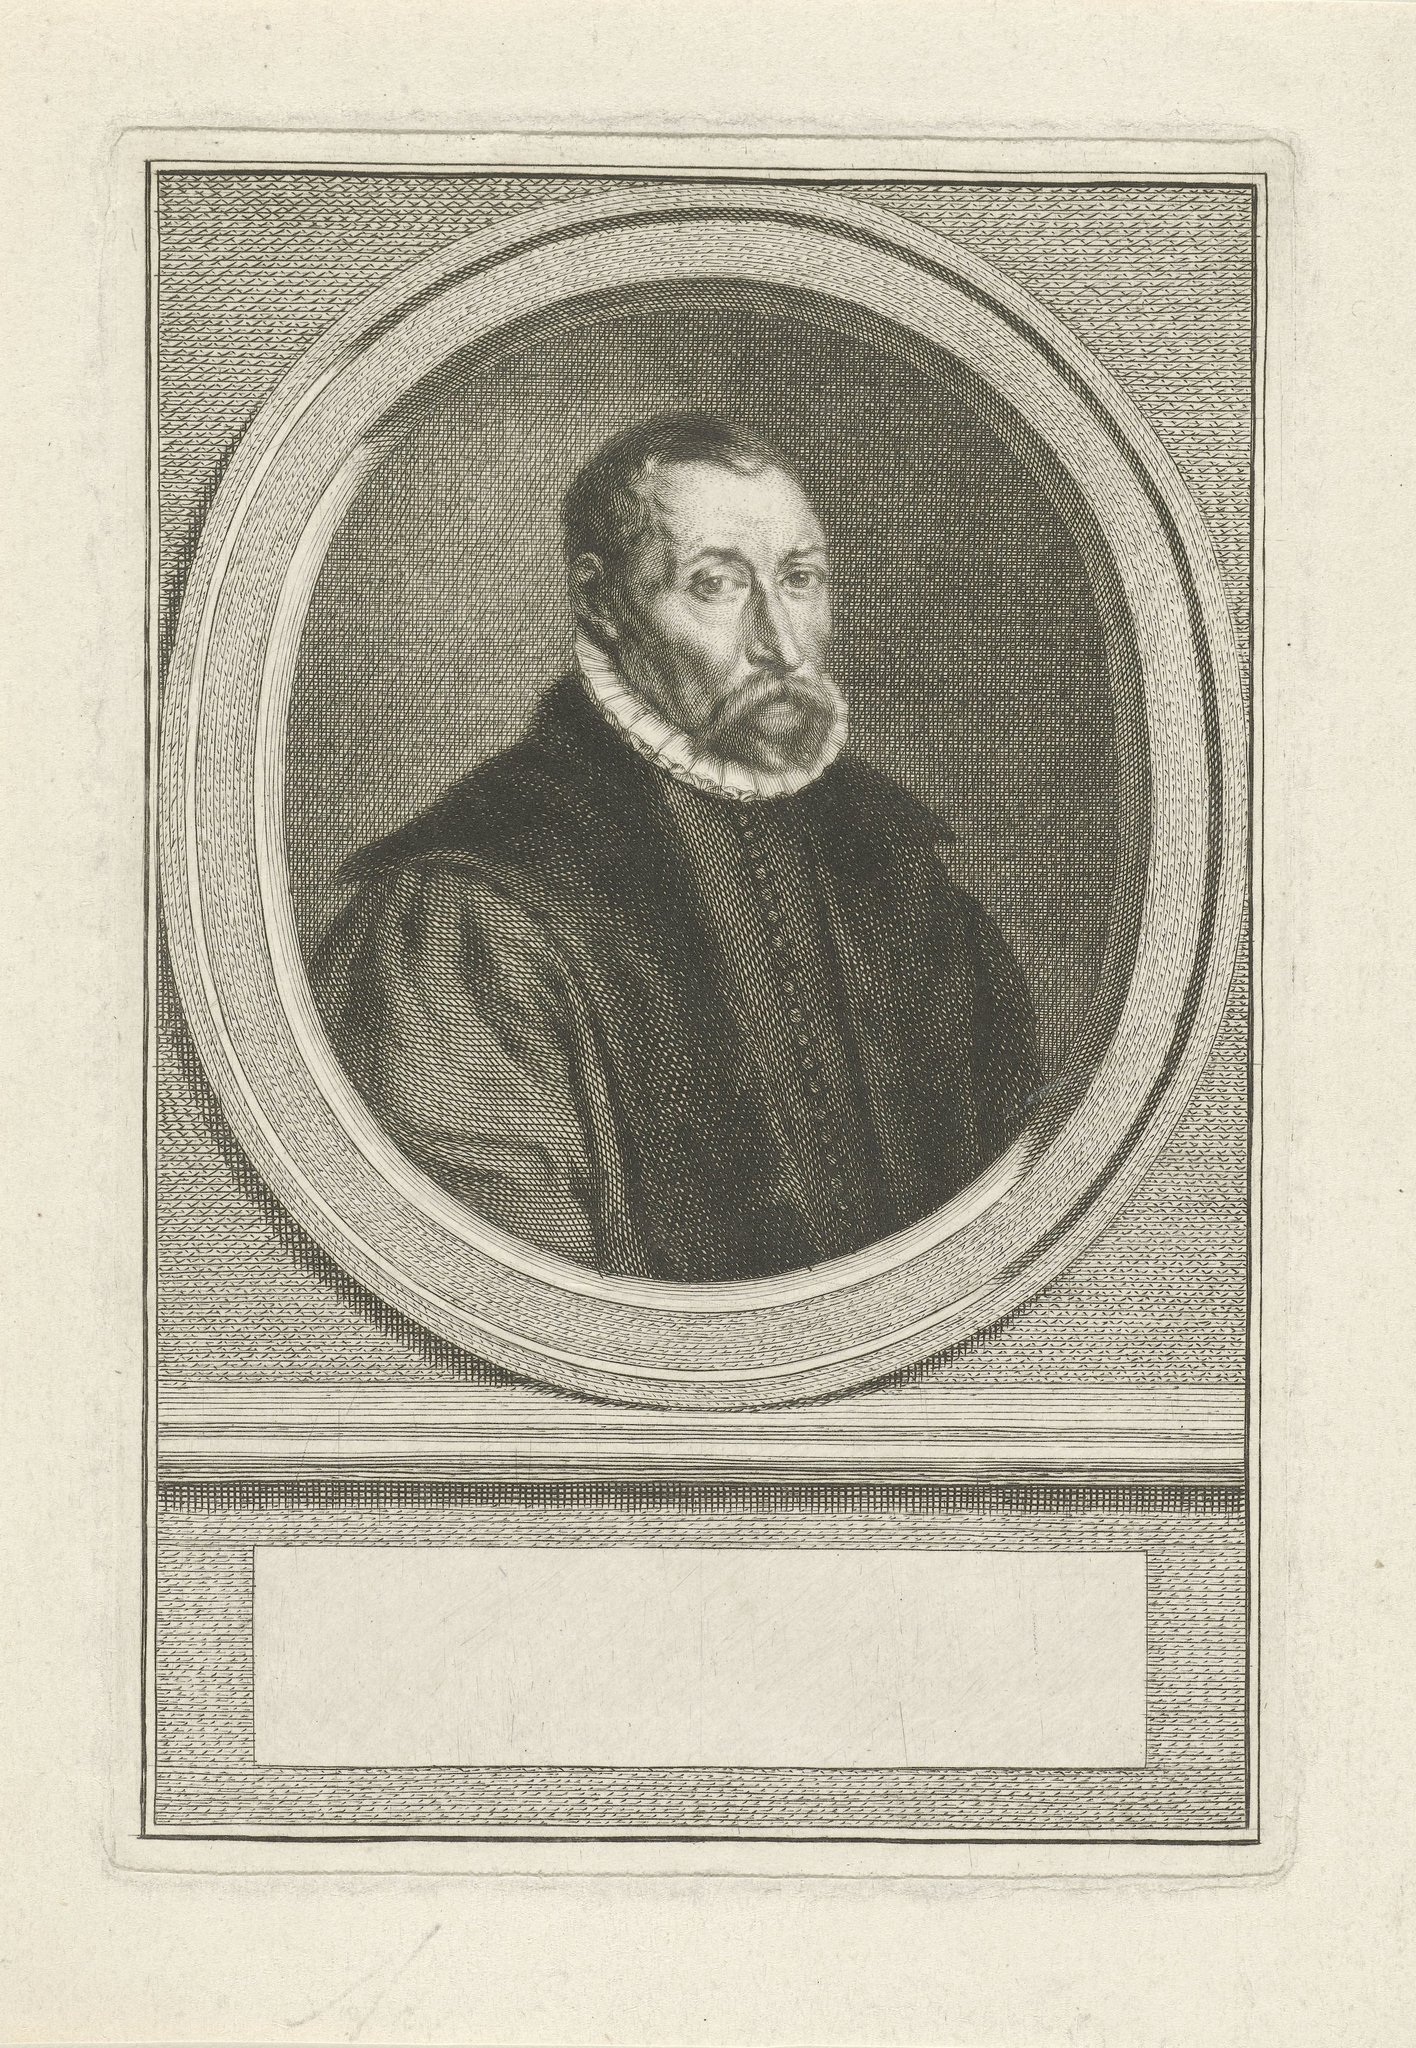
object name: print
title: Portret van Adriaan Reinierszoon Cromhout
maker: jacob houbraken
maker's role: draughtsman, print maker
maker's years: 1698-1780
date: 1747-1759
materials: paper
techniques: engraving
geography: amsterdam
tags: adriaan reinierszoon cromhout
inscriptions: collector's mark: Lugt 2228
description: Proefdruk van de prent oorspronkelijk bedoeld voor: Jan Wagenaar, Vaderlandsche historie, vervattende de geschiedenissen der nu Vereenigde Nederlanden, inzonderheid die van Holland (...), 21 delen. Amsterdam, Isaak Tirion, 1749-59.